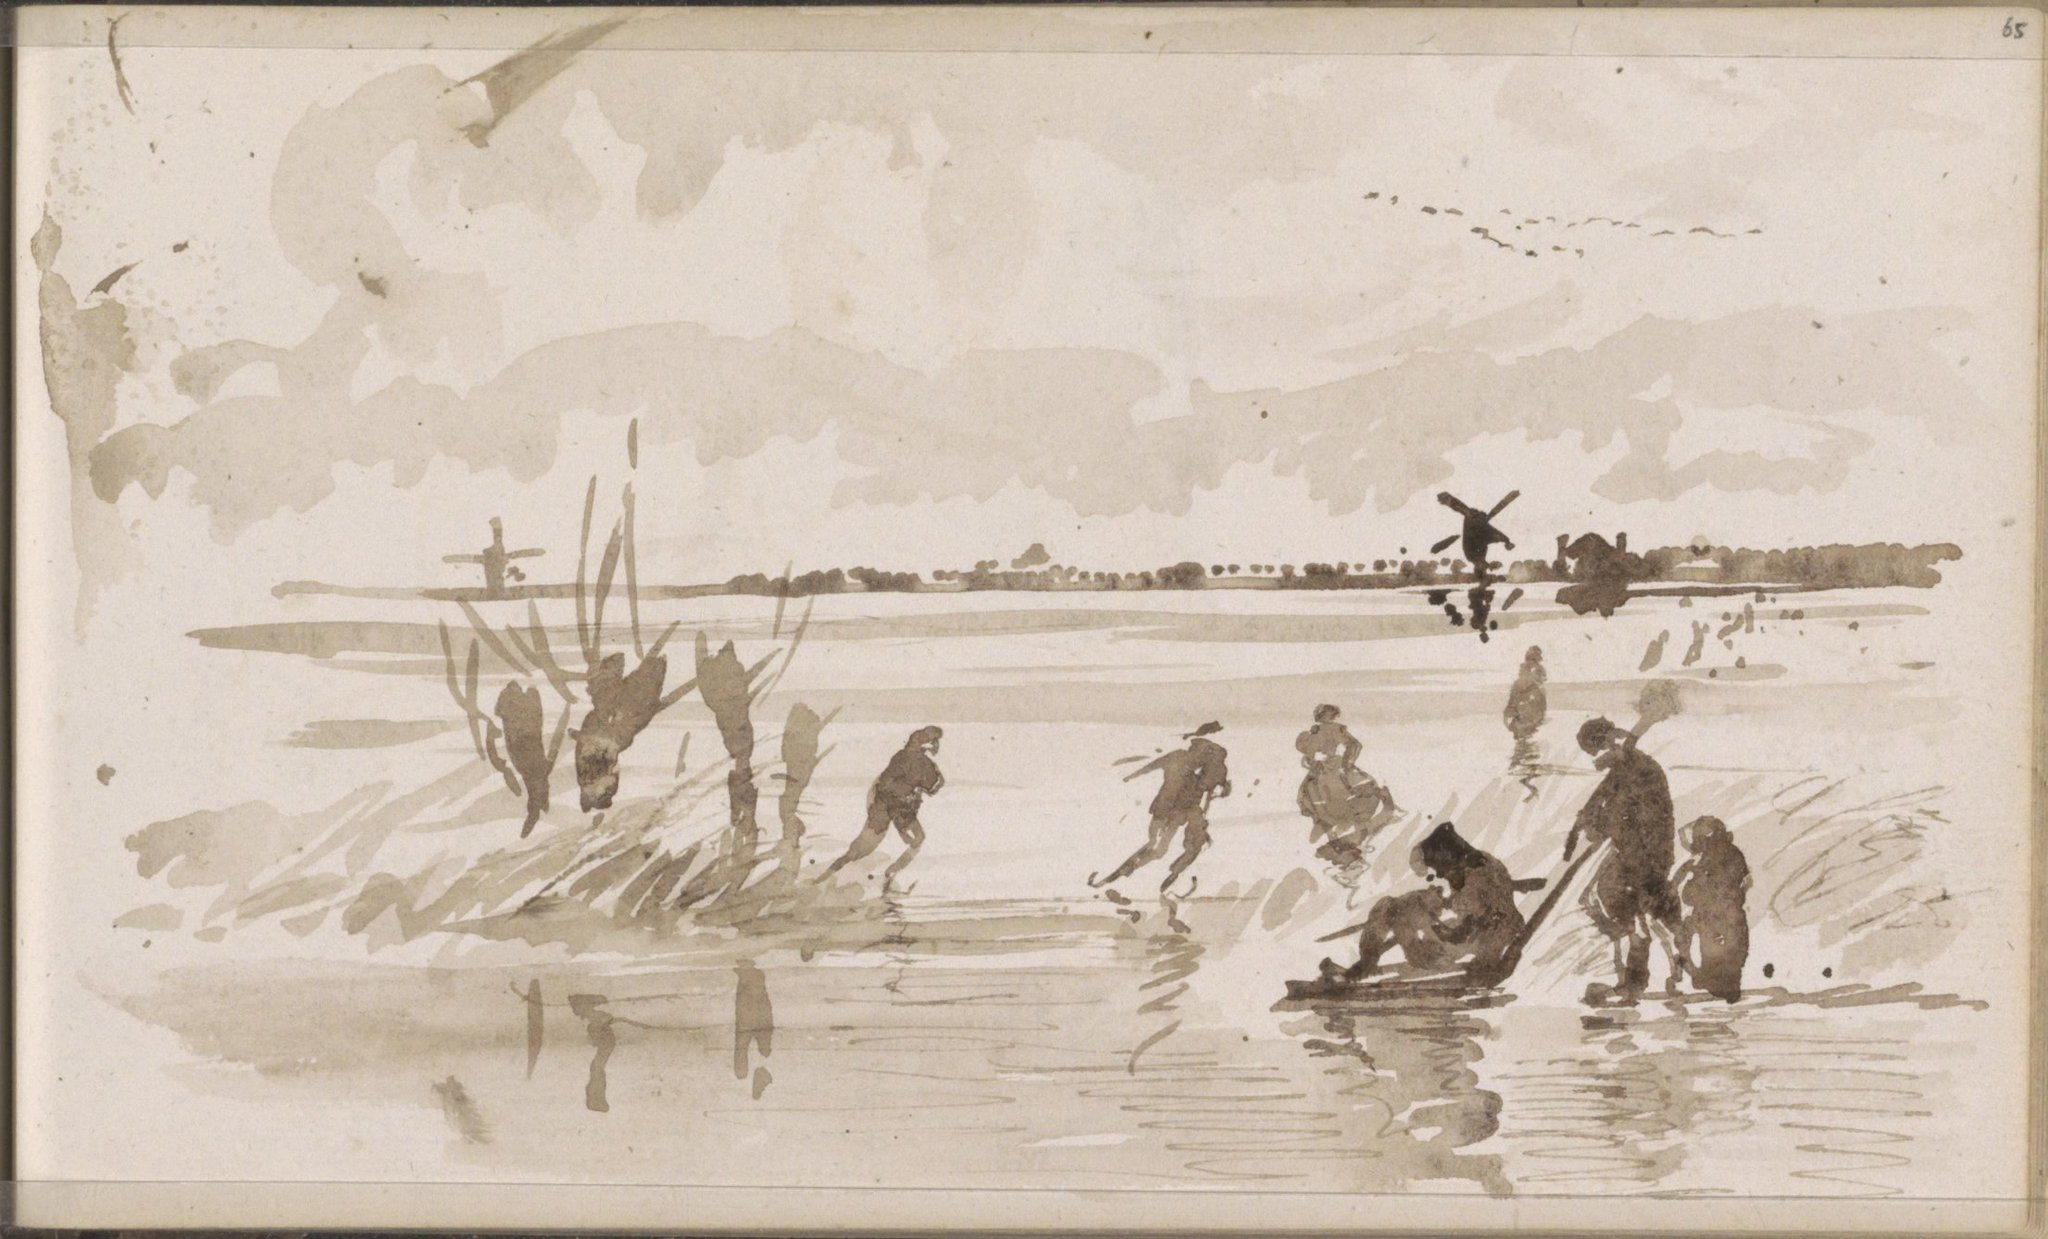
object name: sketchbook leaf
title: River Landscape with Skaters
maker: johannes tavenraat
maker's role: draughtsman, painter, print maker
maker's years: 1809-1881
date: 1864-1880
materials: ink, paper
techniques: brush, pen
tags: windmill in landscape, skates (winter sports), landscapes with waters, waterscapes, seascapes (in the temperate zone) (+ landscape with figures, staffage)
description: Blad 65 recto uit een schetsboek met 98 bladen.